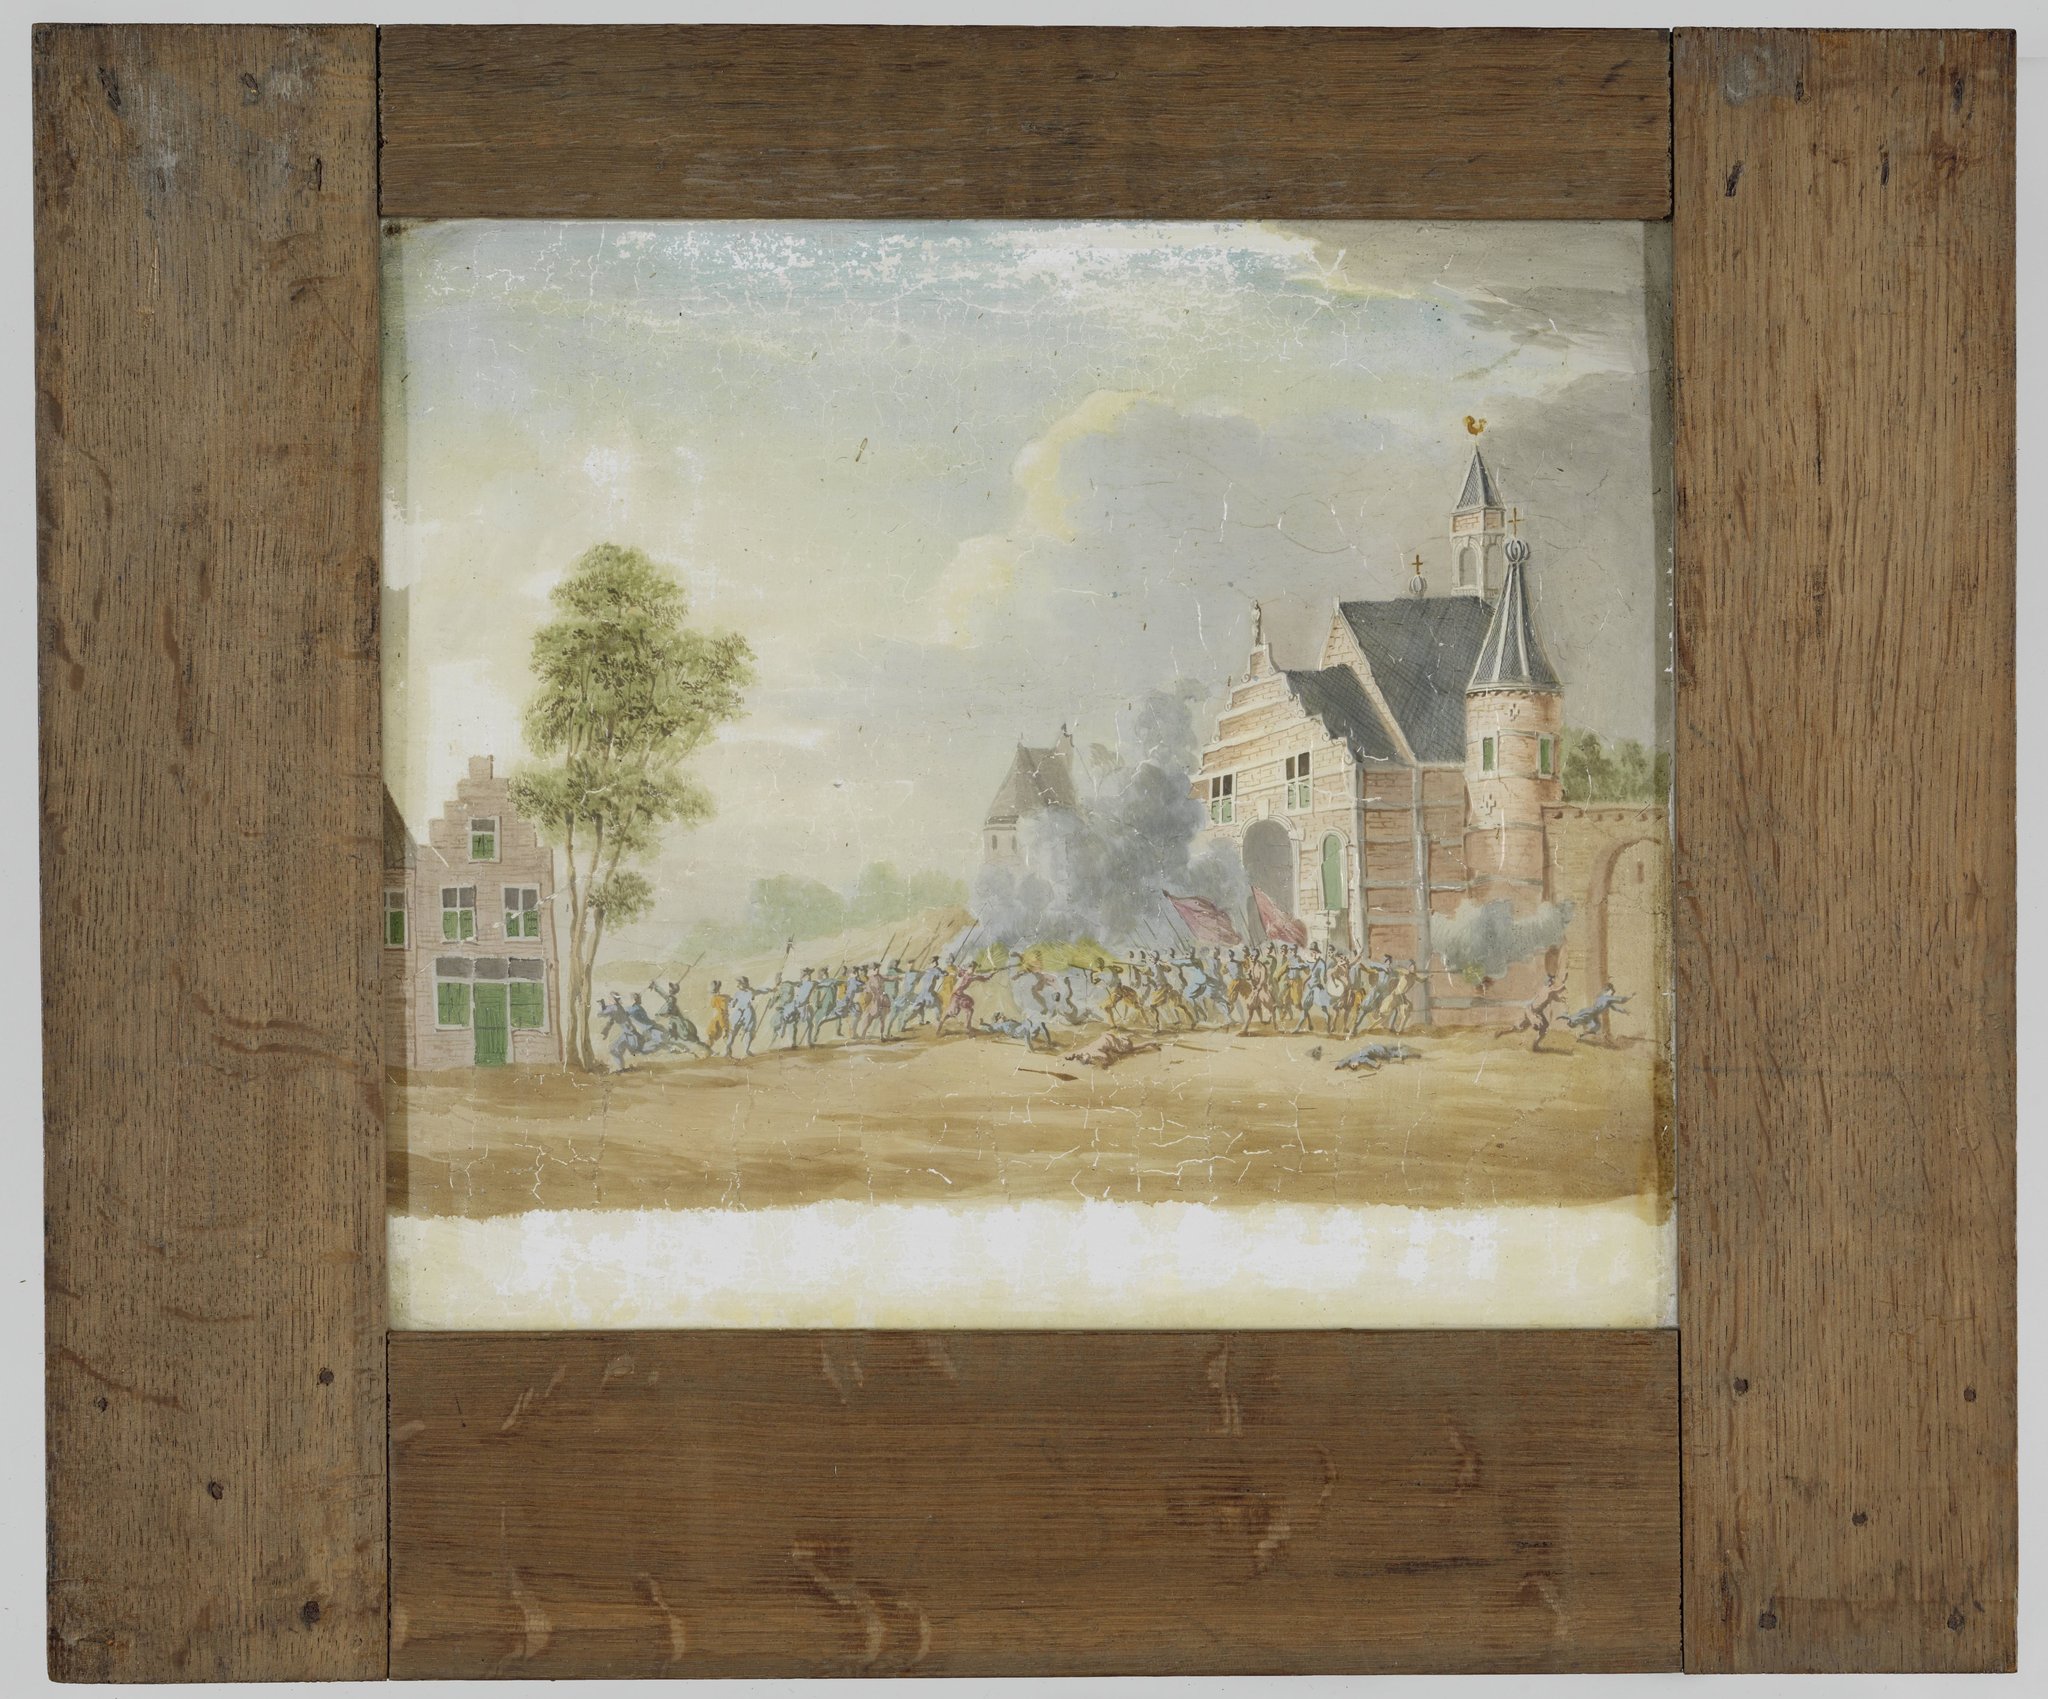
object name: lantern slide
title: Diafanorama van een veldslag op een dorpsplein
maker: Anonymous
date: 1750-1830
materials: glass, wood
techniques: painted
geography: netherlands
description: Rechts van de plaat is een huisje zichtbaar met een boom. Aan de linkerzijde staat een kerk. Hiertussen zijn mannen met zwaarden met elkaar aan het vechten. Ook veel rook. De plaat is geheel wit ingekleurd.